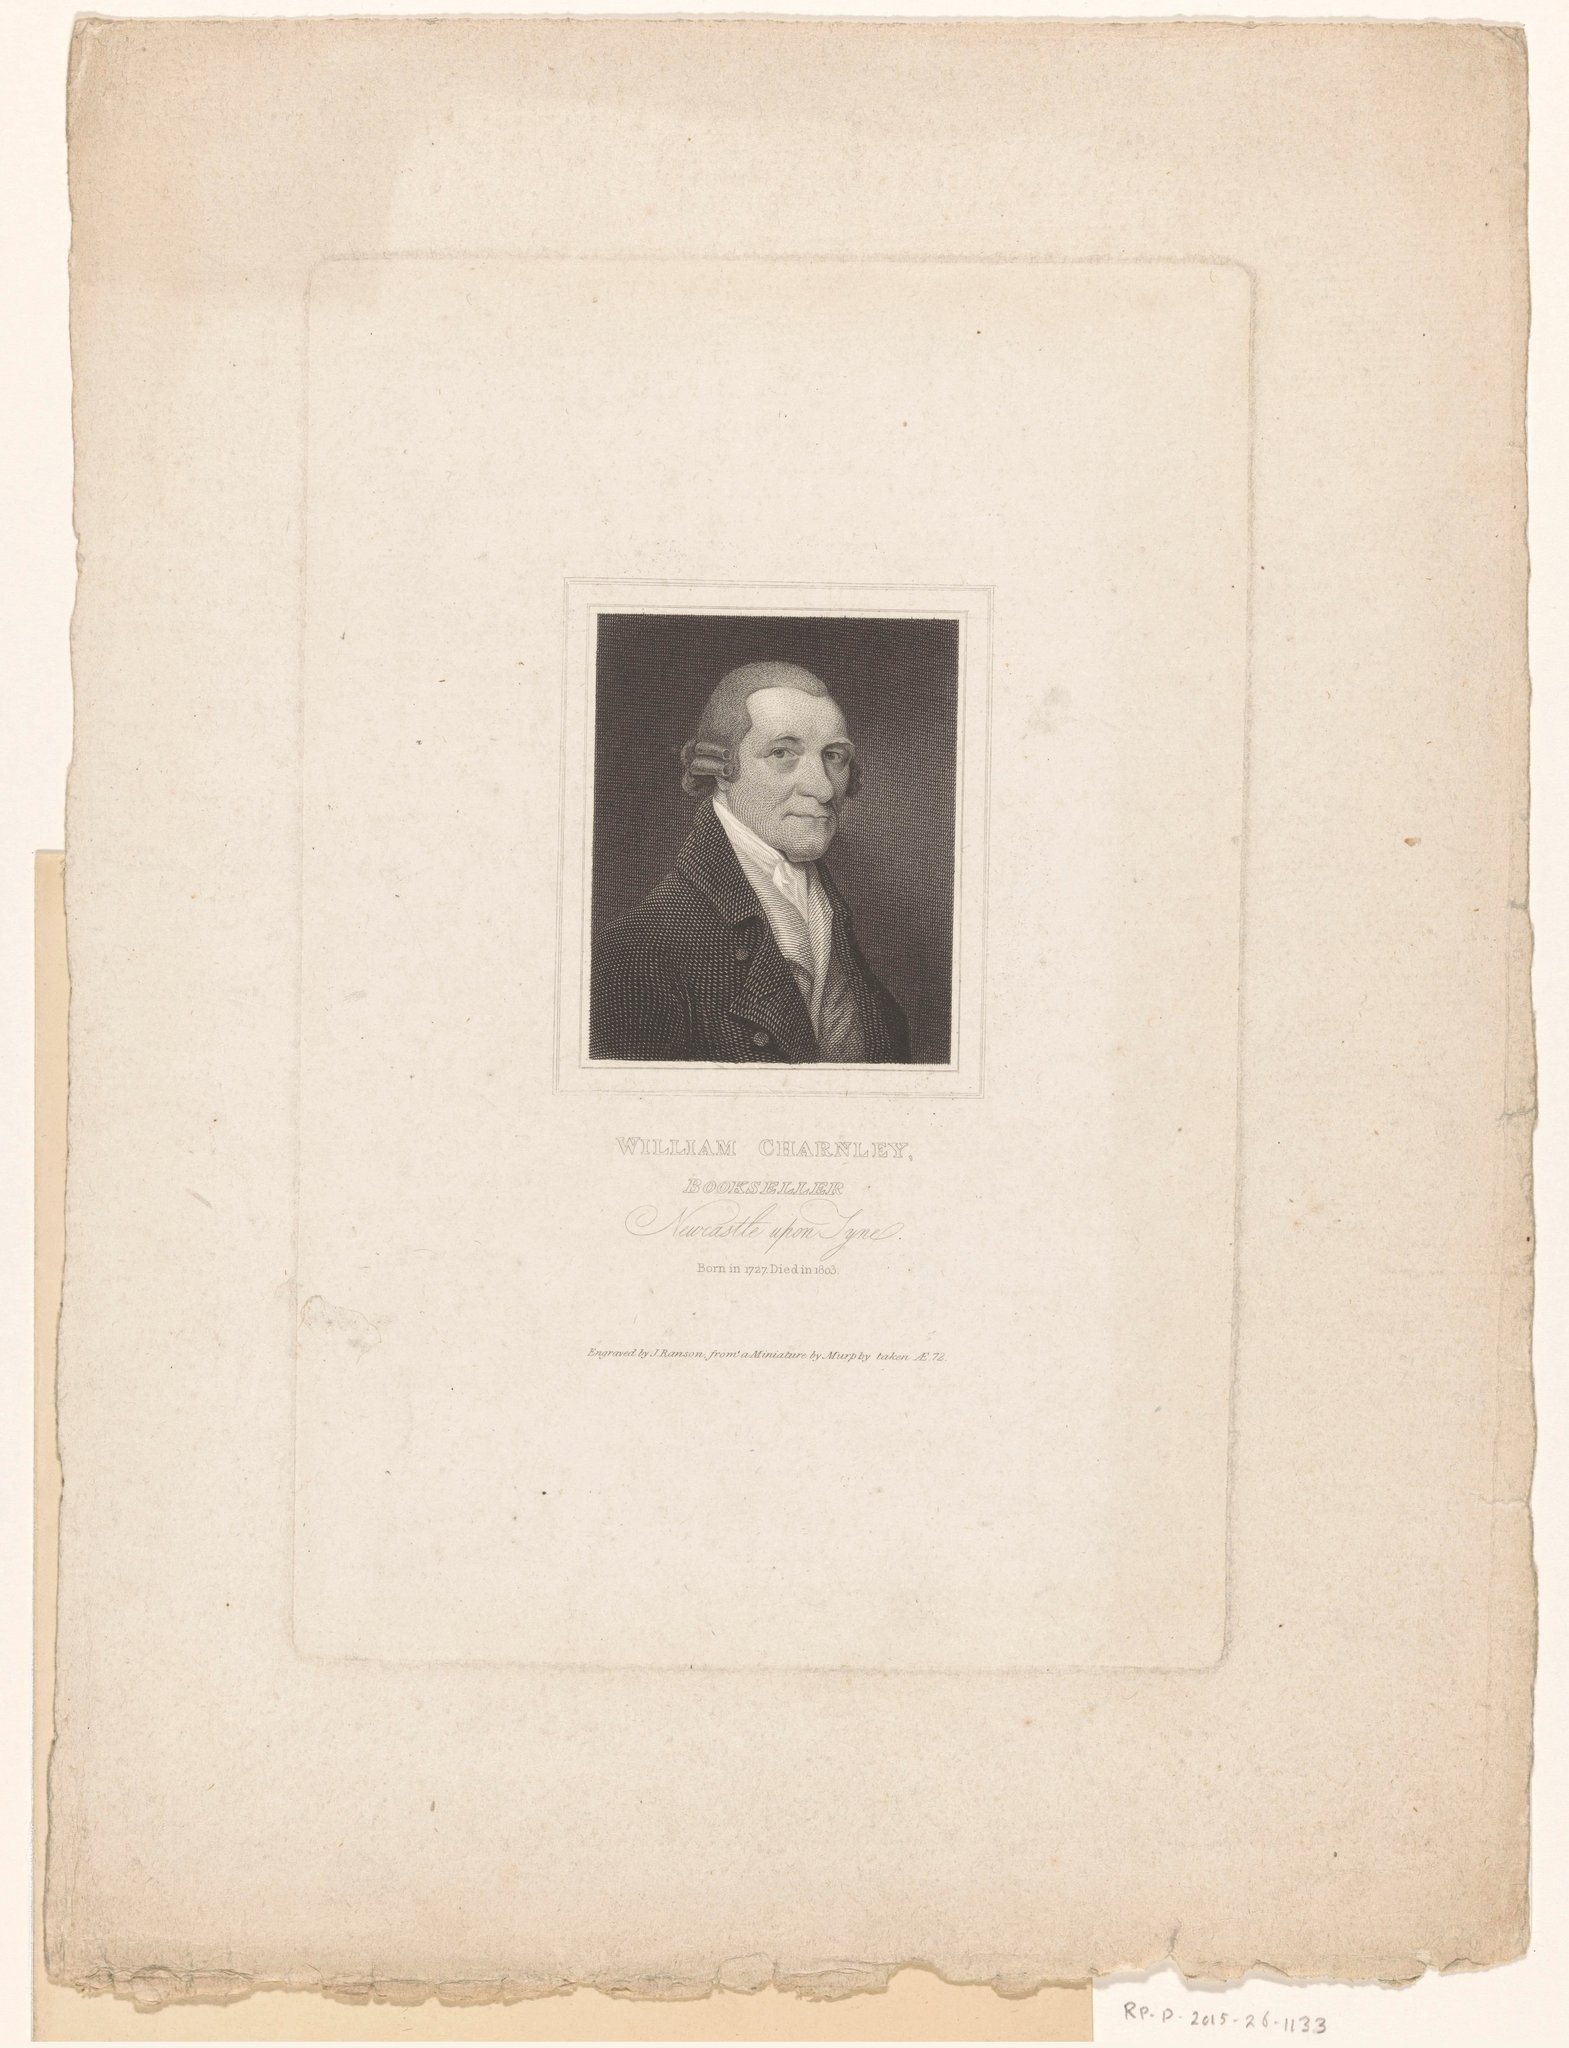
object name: print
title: William Charnley, Bookseller Newcastle upon Tyne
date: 1817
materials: paper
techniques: engraving, etching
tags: publisher, bookseller, book-shop, bookseller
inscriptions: collector's mark: Lugt 2228, dedication: ‘To Thomas Bell by ECharnley’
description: Bij de prent wordt een gedrukte verklaring bewaard, gedateerd 3 februari 1817. Hierin verklaart Emerson Charnley, de zoon van geportretteerde, dat hij het portret heeft laten maken uit respect voor zijn vader. Dit document bevat een handgeschreven opdracht van Emerson Charnley aan Thomas Bell, mogelijk de boekverzamelaar Thomas Bell (1785-1860).